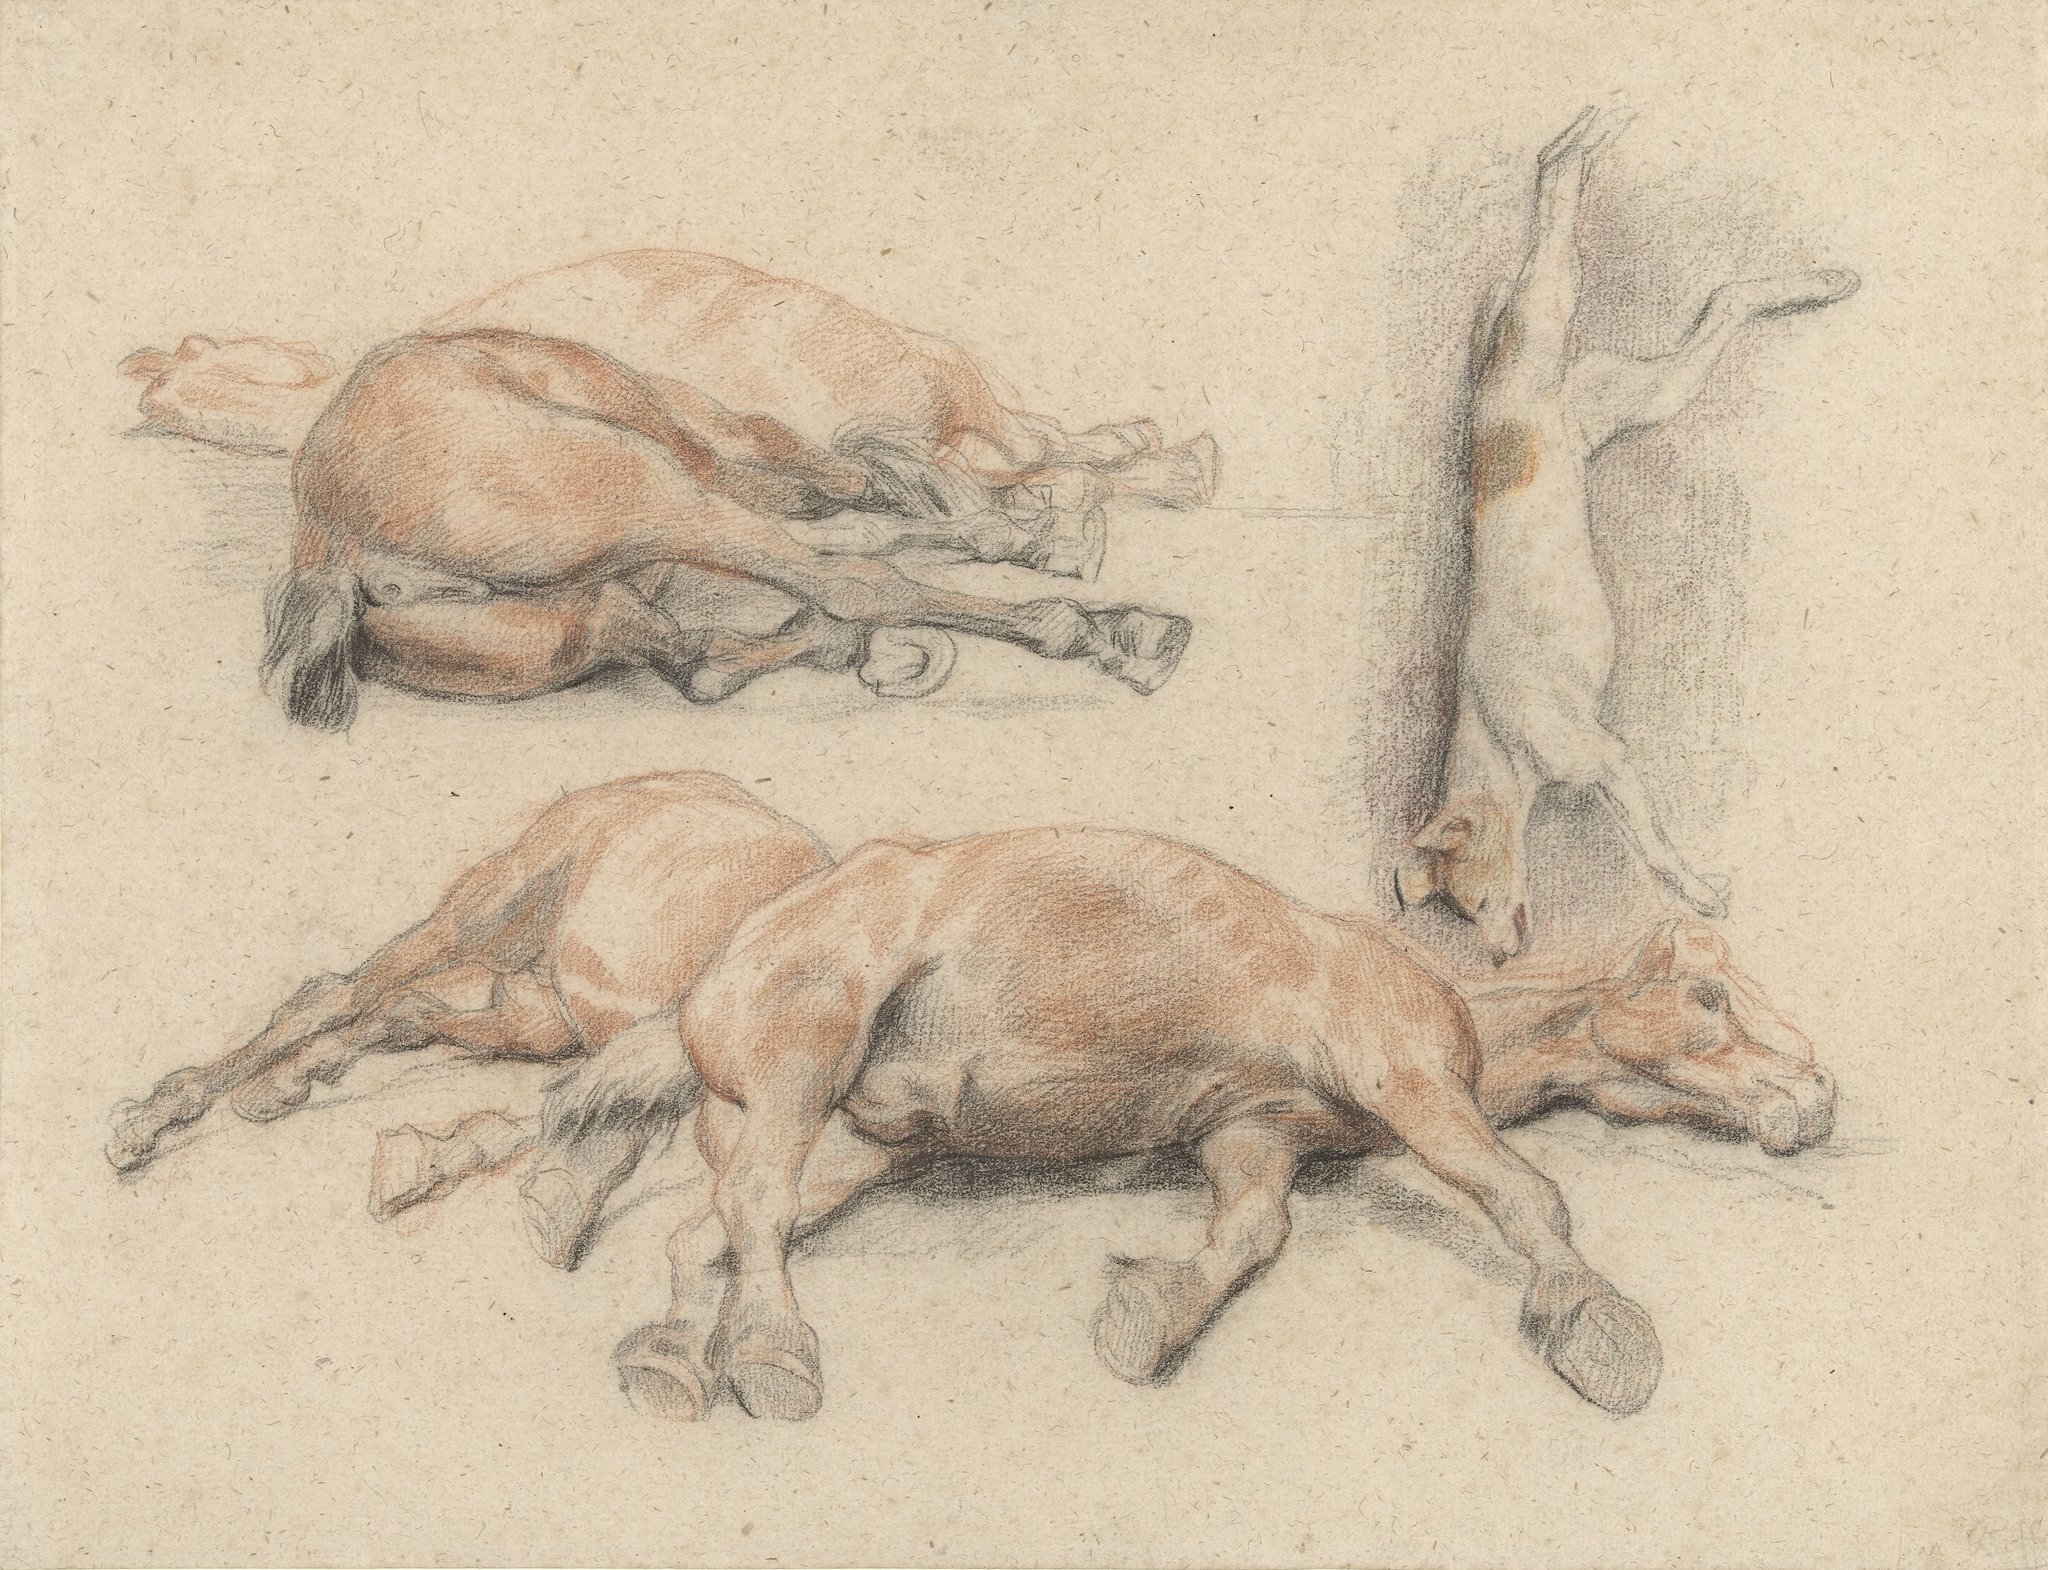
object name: drawing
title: Studies van een paardenkadaver en een dode opgehangen hond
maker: denis auguste marie raffet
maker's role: draughtsman, print maker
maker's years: 1804-1860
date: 1814-1860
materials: chalk, paper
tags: dog